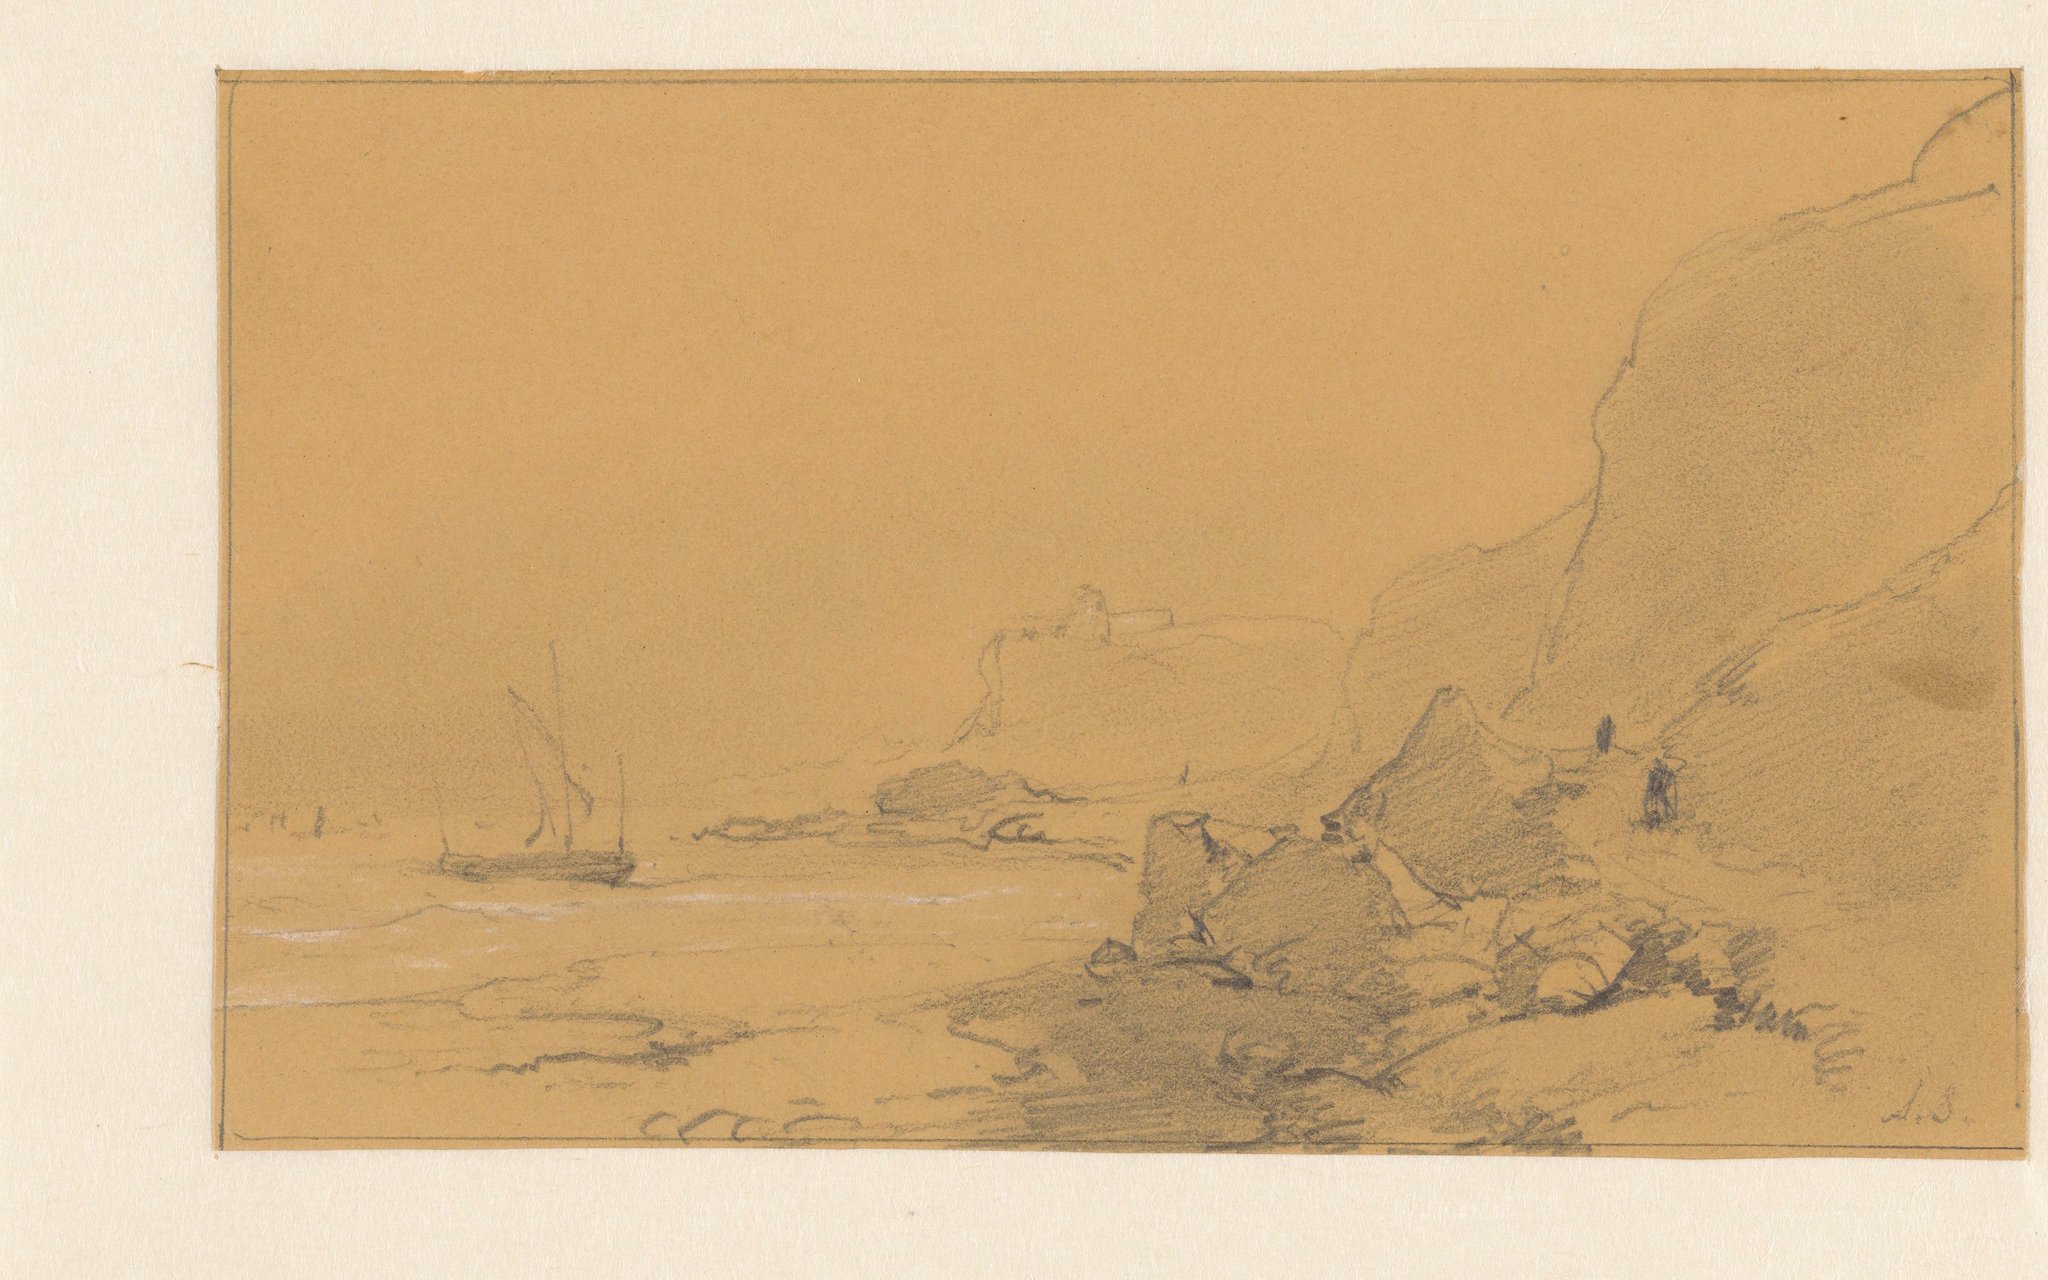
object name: drawing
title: Rotsachtige zeekust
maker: andreas schelfhout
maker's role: draughtsman, painter, print maker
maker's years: 1787-1870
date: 1797-1870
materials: paper, pencil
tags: coast